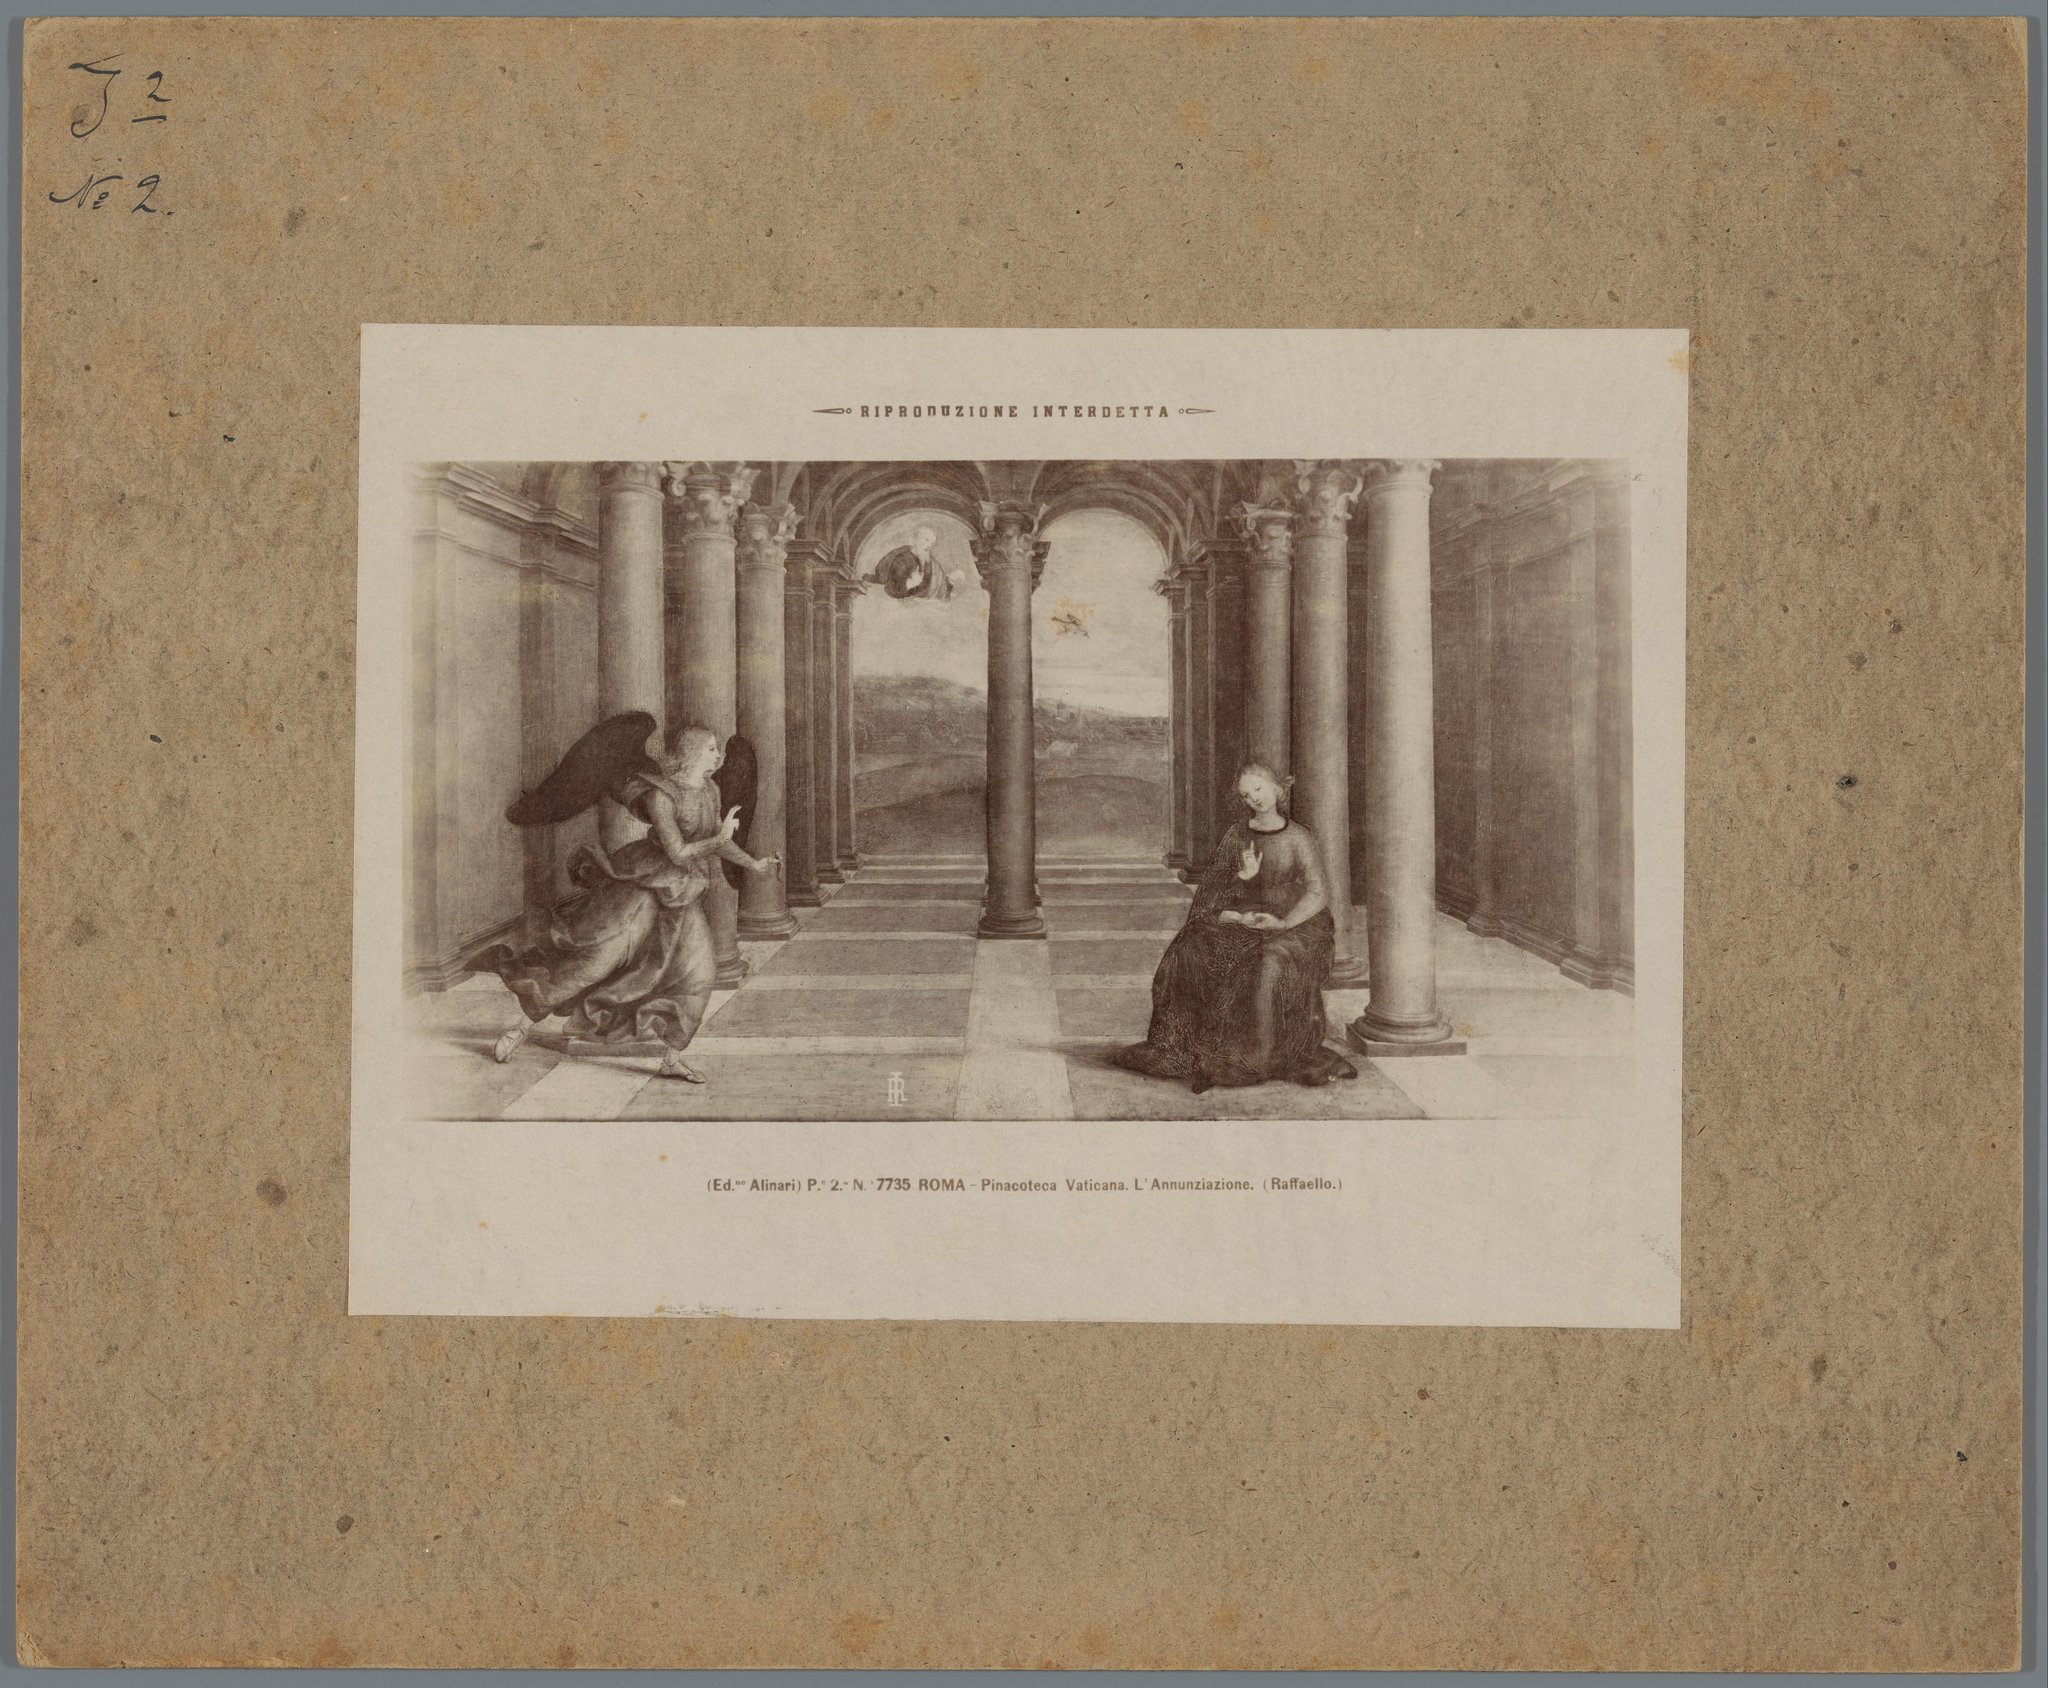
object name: photograph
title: ROMA- Pinacoteca Vaticana. L'Annunziazione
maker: rafaël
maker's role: painter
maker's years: 1483-1520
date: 1875-1900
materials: cardboard, photographic support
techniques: albumen print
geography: italy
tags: the annunciation: mary sitting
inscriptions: collector's mark: Lugt 3937, number: ‘P.e 2.a N.o 7735.’, inscription: